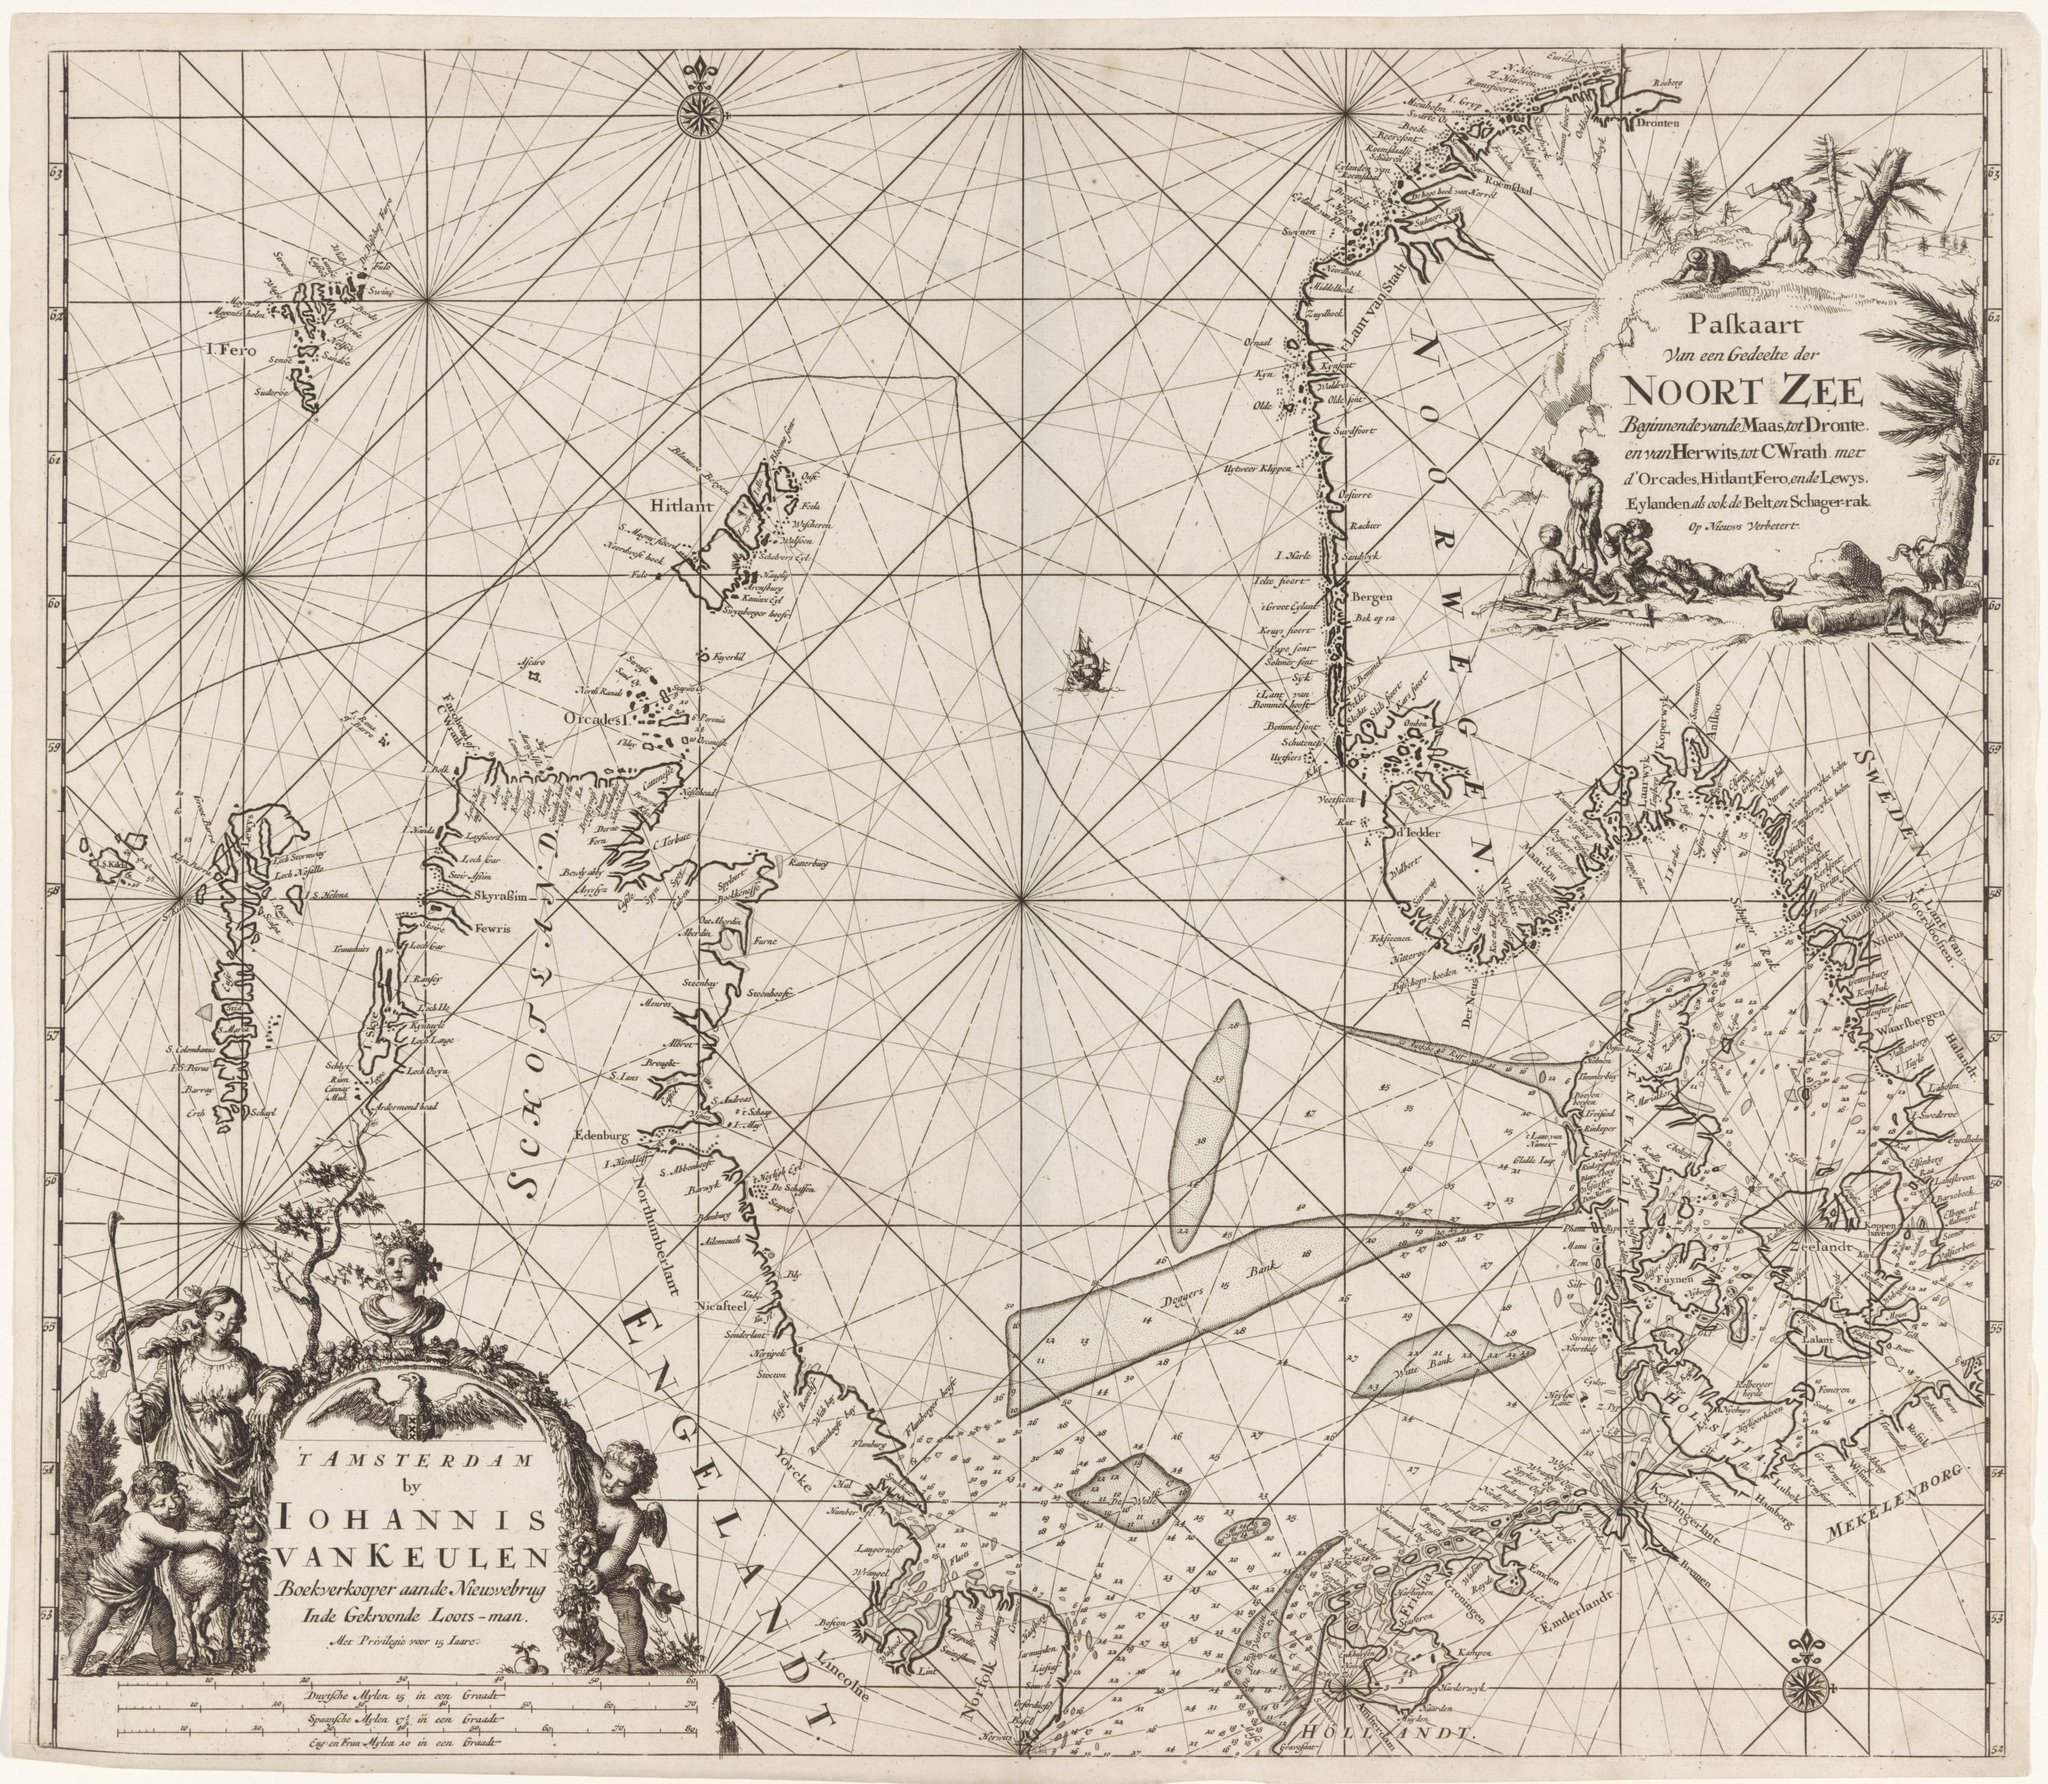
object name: print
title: Paskaart van een Gedeelte der Noort Zee Beginnende van de Maas, tot Dronte. en van Herwits, tot C. Wrath met d'Orcades, Hitlant, Fero, ende Lewys, Eylanden als ook de Belt en Schager-rak Op Nieuws Verbetert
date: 1681-1799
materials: paper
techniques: etching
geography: amsterdam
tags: sailing-ship, sailing-boat, herding, herdsman, herdswoman, shepherd, shepherdess, cowherd, etc., maps, atlases, cupids: 'amores', 'amoretti', 'putti', zuiderzee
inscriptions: collector's mark: Lugt 2228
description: Paskaart van een groot deel van de Noordzee, met twee kompasrozen, het Noorden ligt boven. Rechtsboven een cartouche met de titel, omringd door houthakkers, herders en twee geiten. Linksonder een cartouche met het adres van de uitgever, waar onder de schaal in Duitse, Spaanse en Engelse of Franse mijlen. Het adres wordt geflankeerd door putti en een herderin met een schaap.